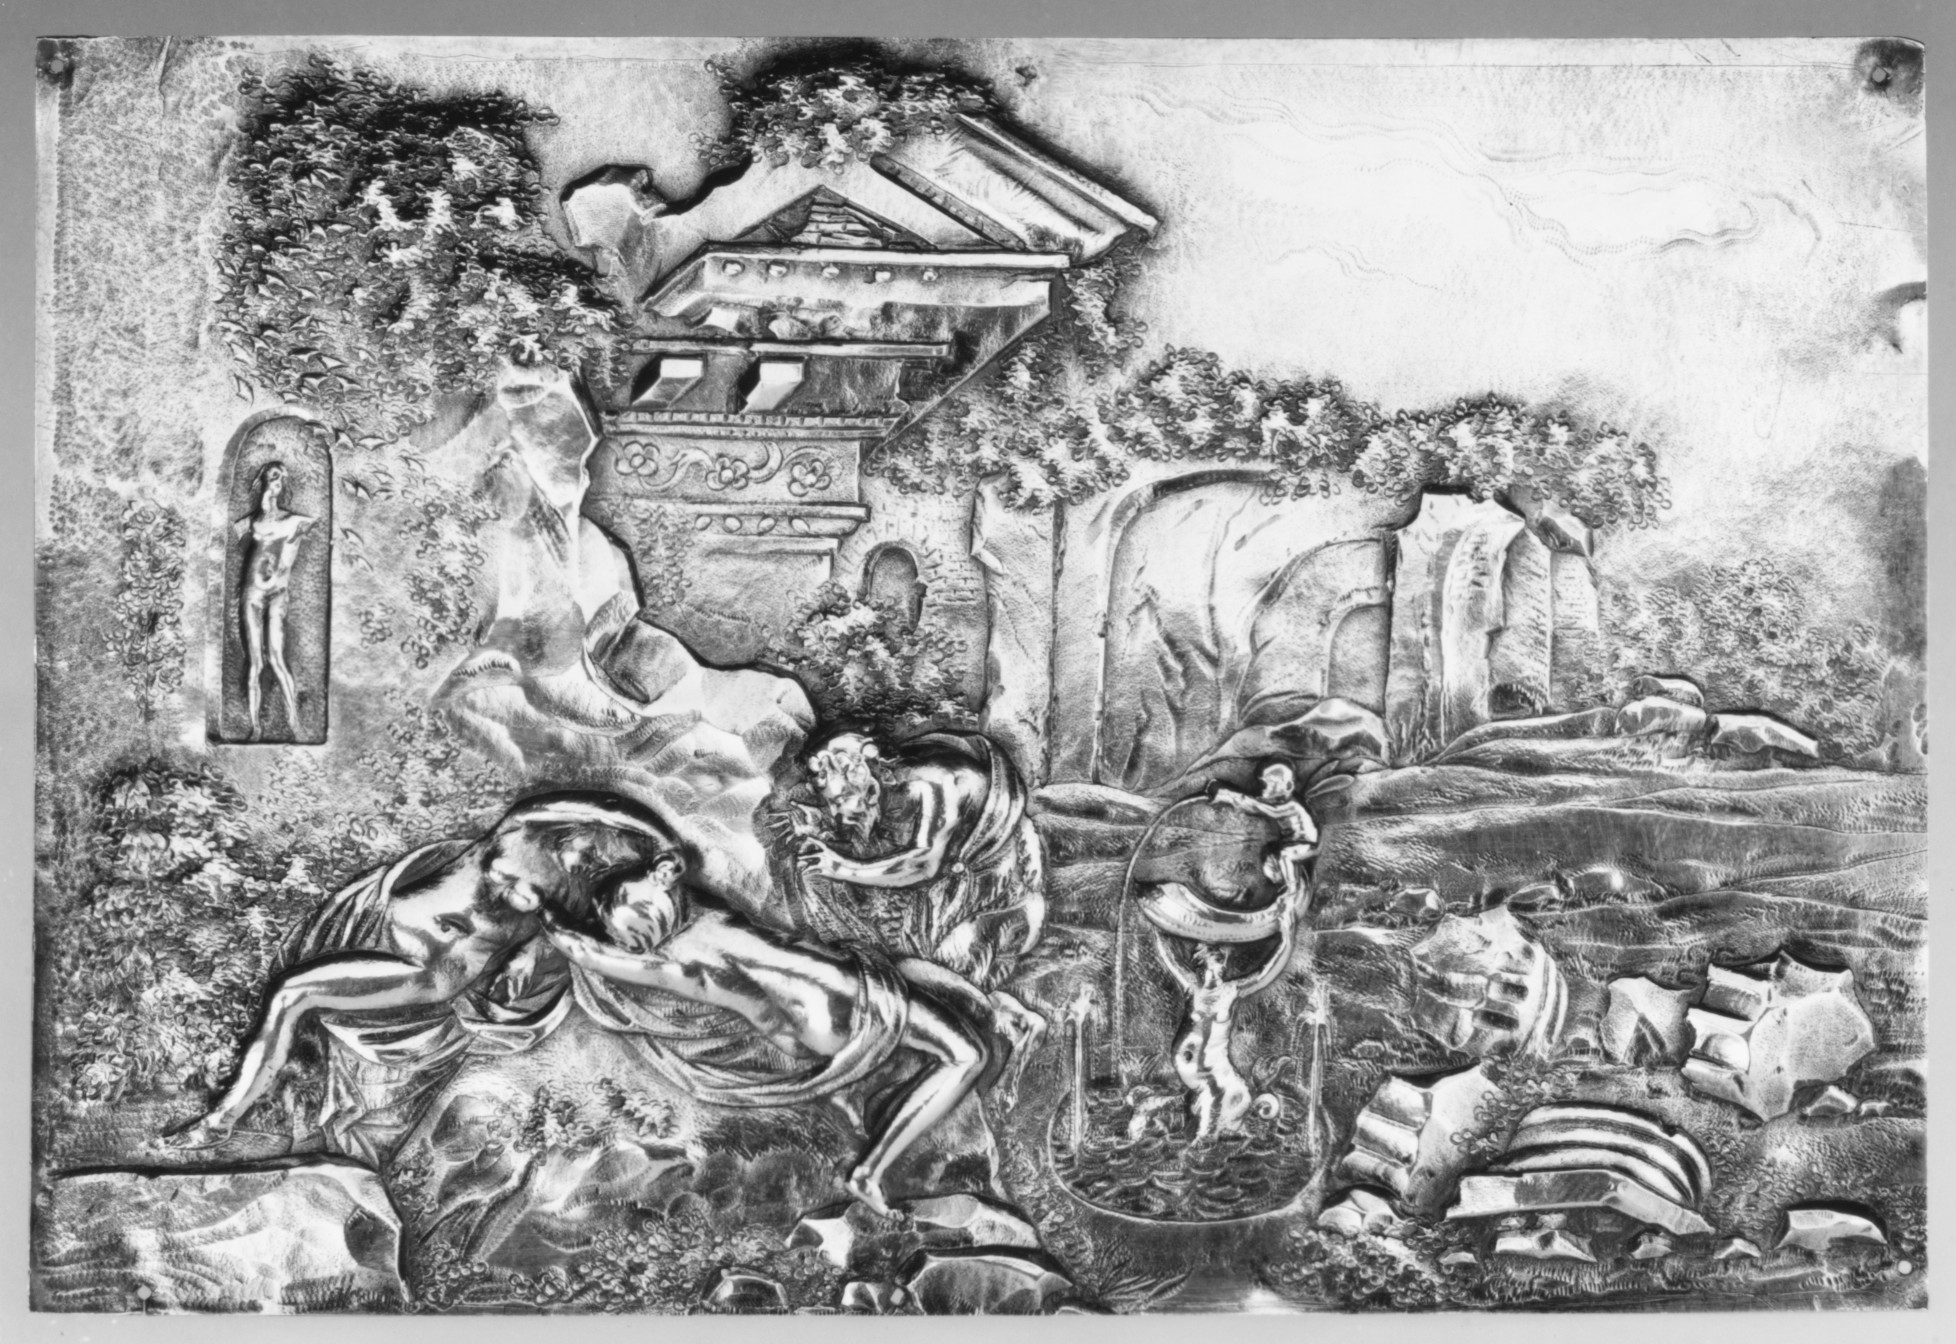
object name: relief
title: Nymphs and Satyr in a Classical Landscape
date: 1601-1700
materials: silver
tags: nymphs,satyrs